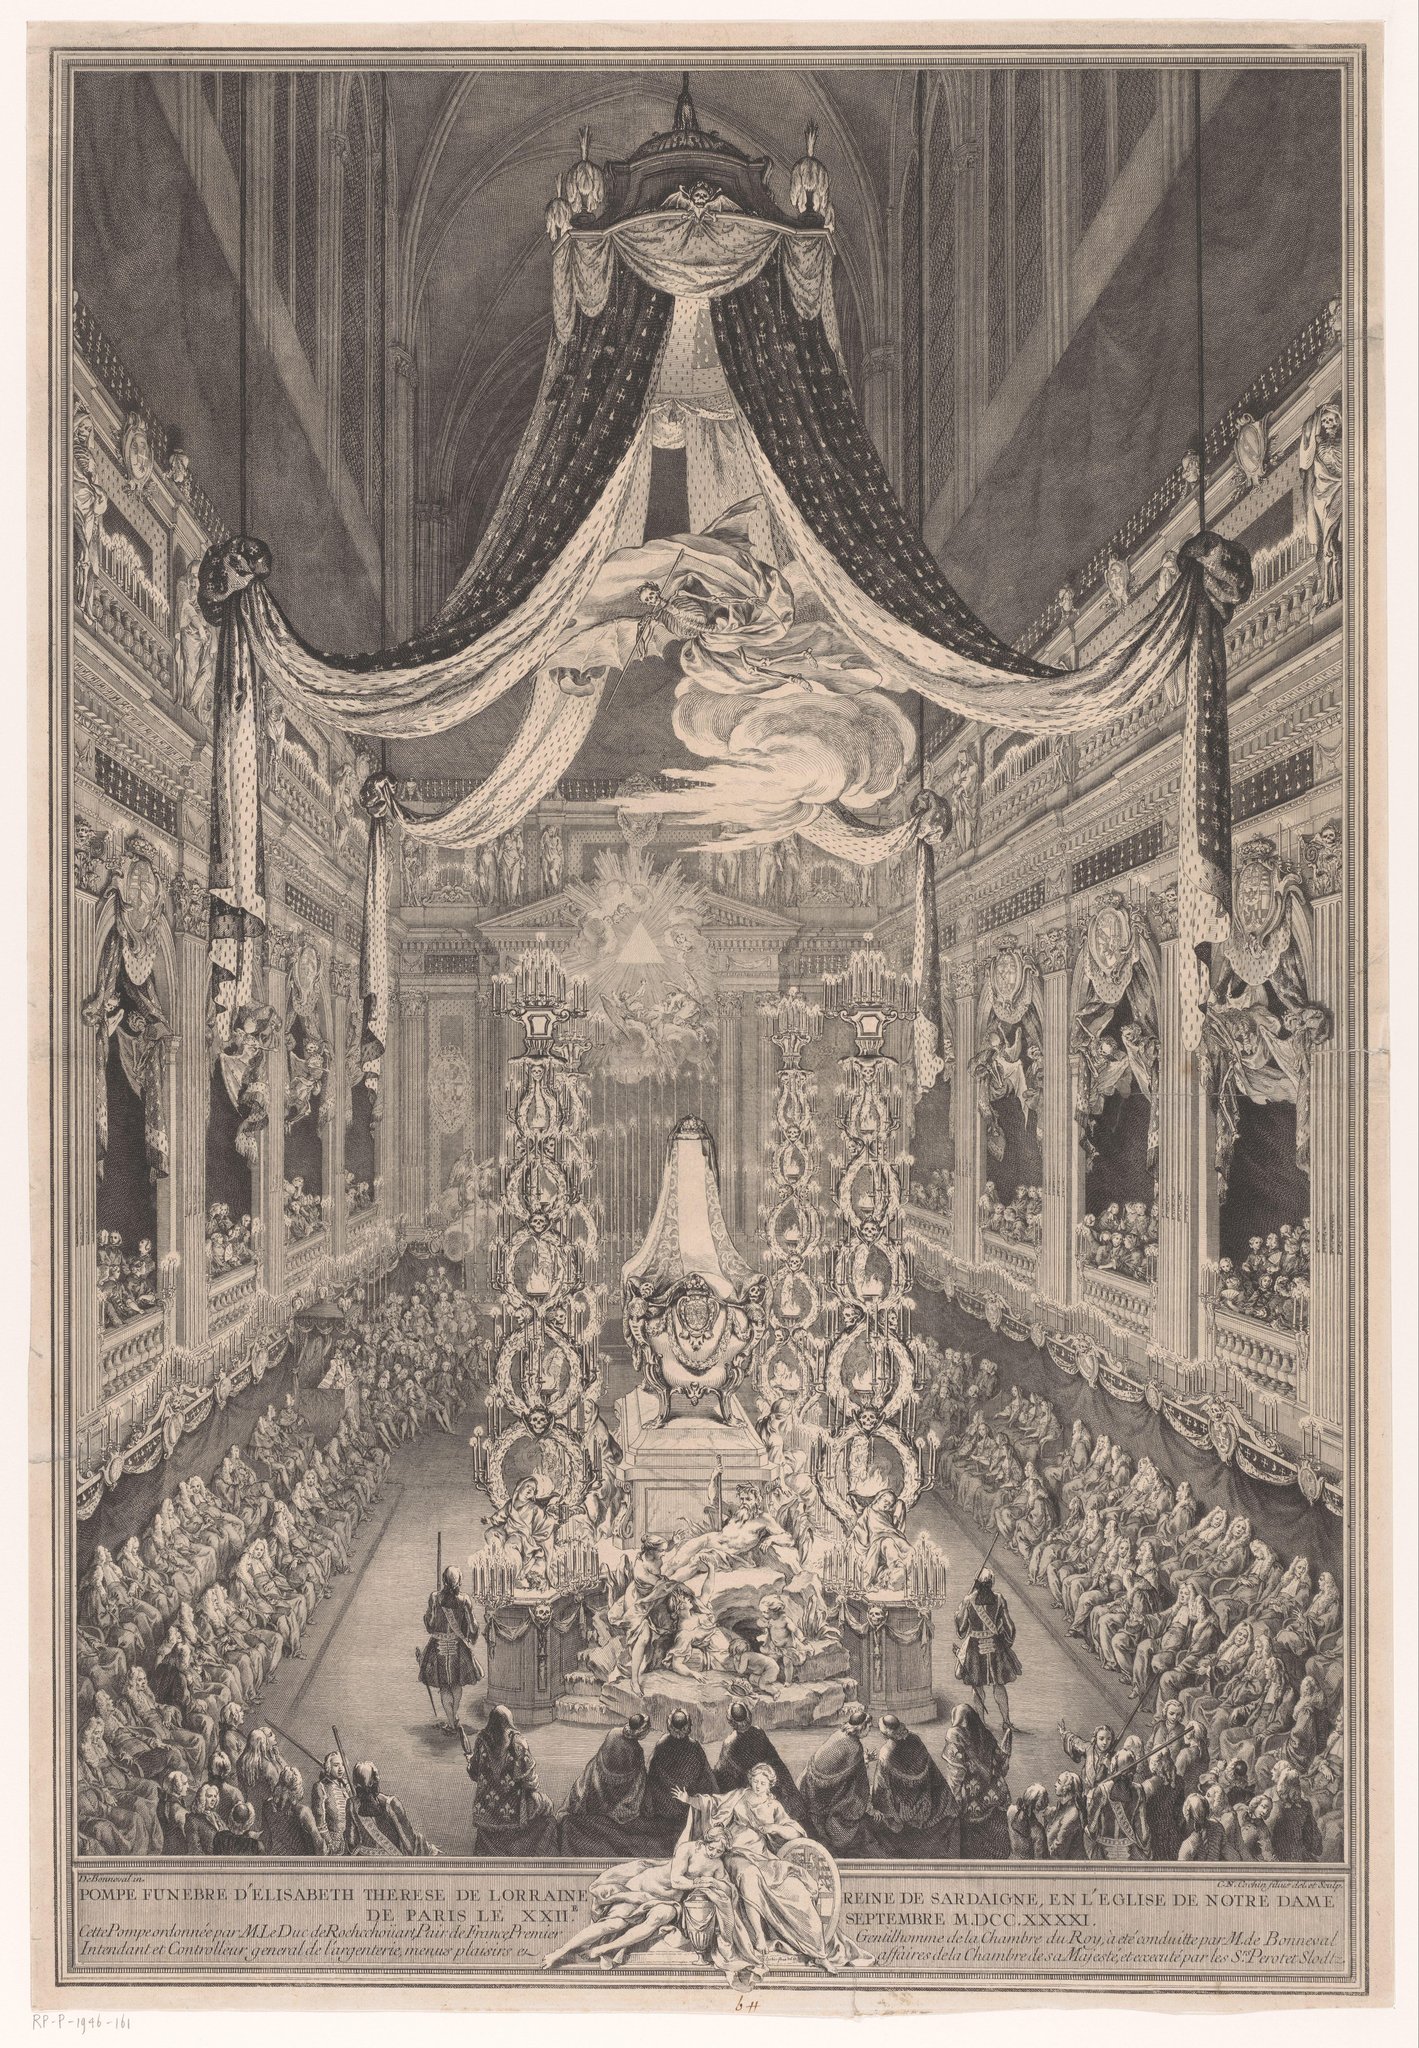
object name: print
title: Praalgraf van Élisabeth-Thérèse de Lorraine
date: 1708-1743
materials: paper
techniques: engraving, etching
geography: france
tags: historical persons - bb - woman, queen, grave, tomb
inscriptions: collector's mark: Lugt 2228, number: ‘6H’